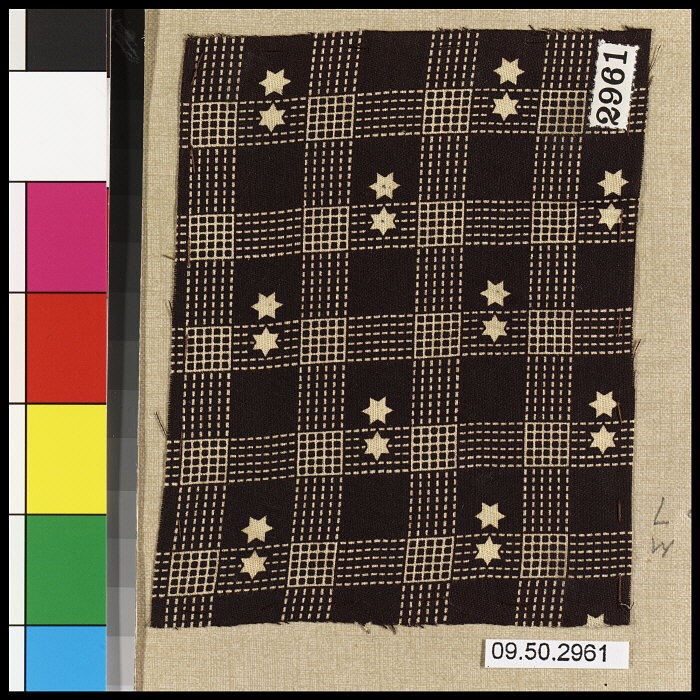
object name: piece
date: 1801-1900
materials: cotton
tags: stars